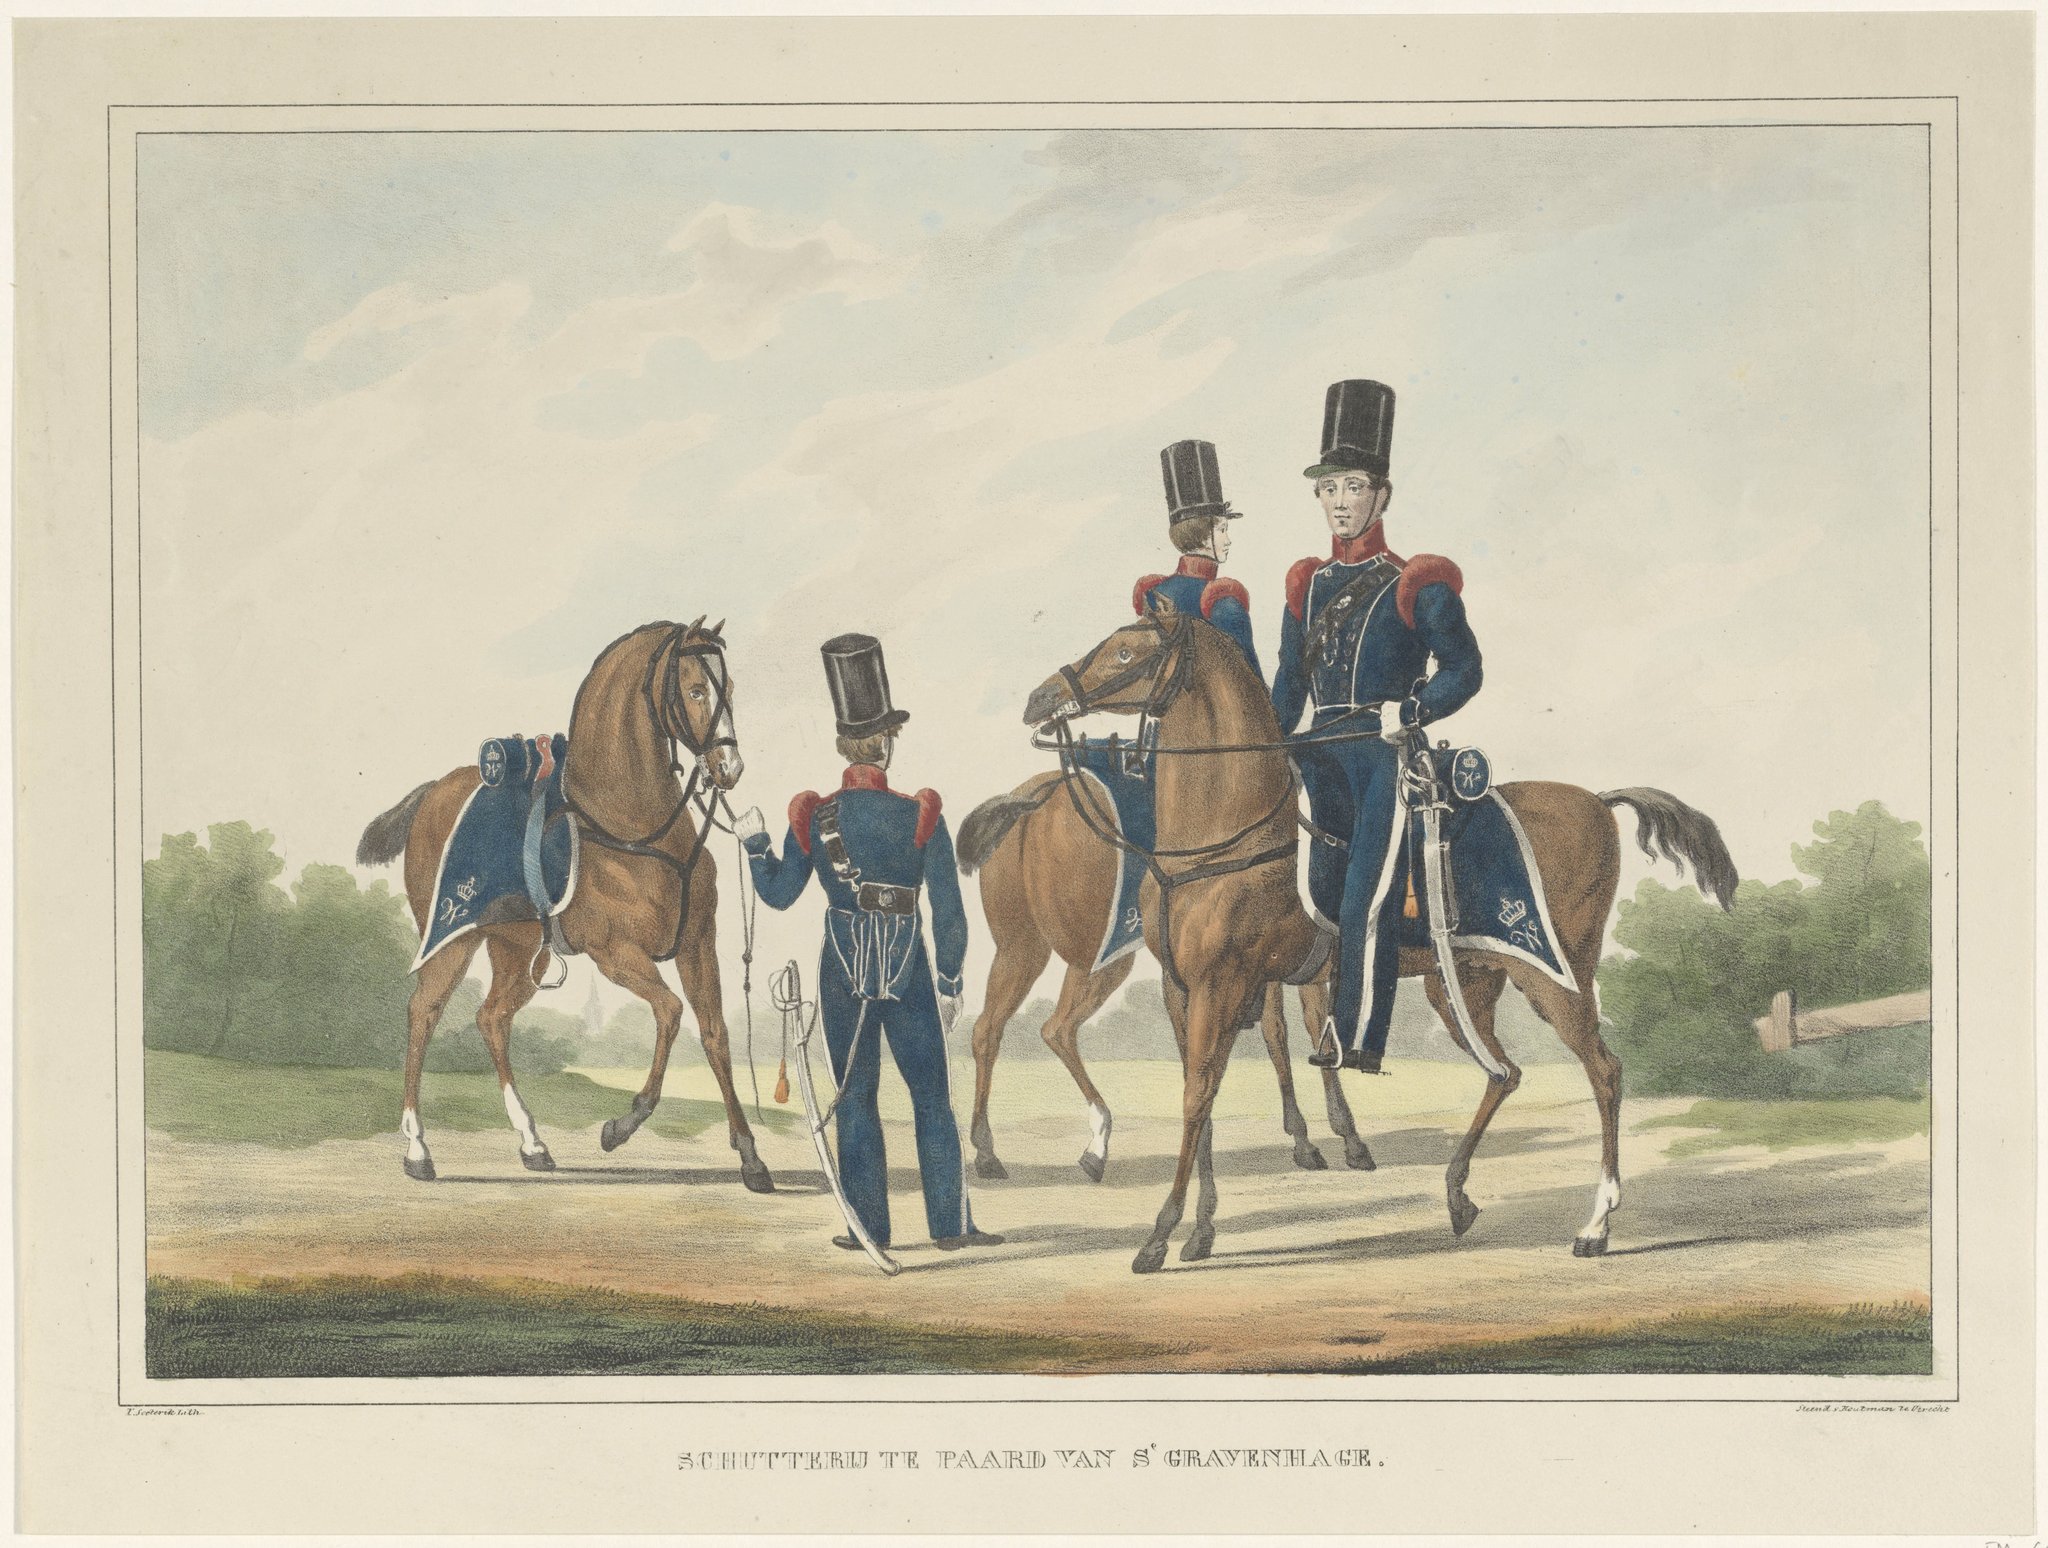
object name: print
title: Schutterij te paard van 's-Gravenhage, 1830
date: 1830-1831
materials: paper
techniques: hand coloring, lithograph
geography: netherlands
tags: (military) uniforms, clothes, costume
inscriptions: collector's mark: Lugt 2228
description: Uniformen van drie militairen van het korps Rijdende Schutterij of Schutterij te Paard van 's-Gravenhage, 1830. Zie ook de pendant.